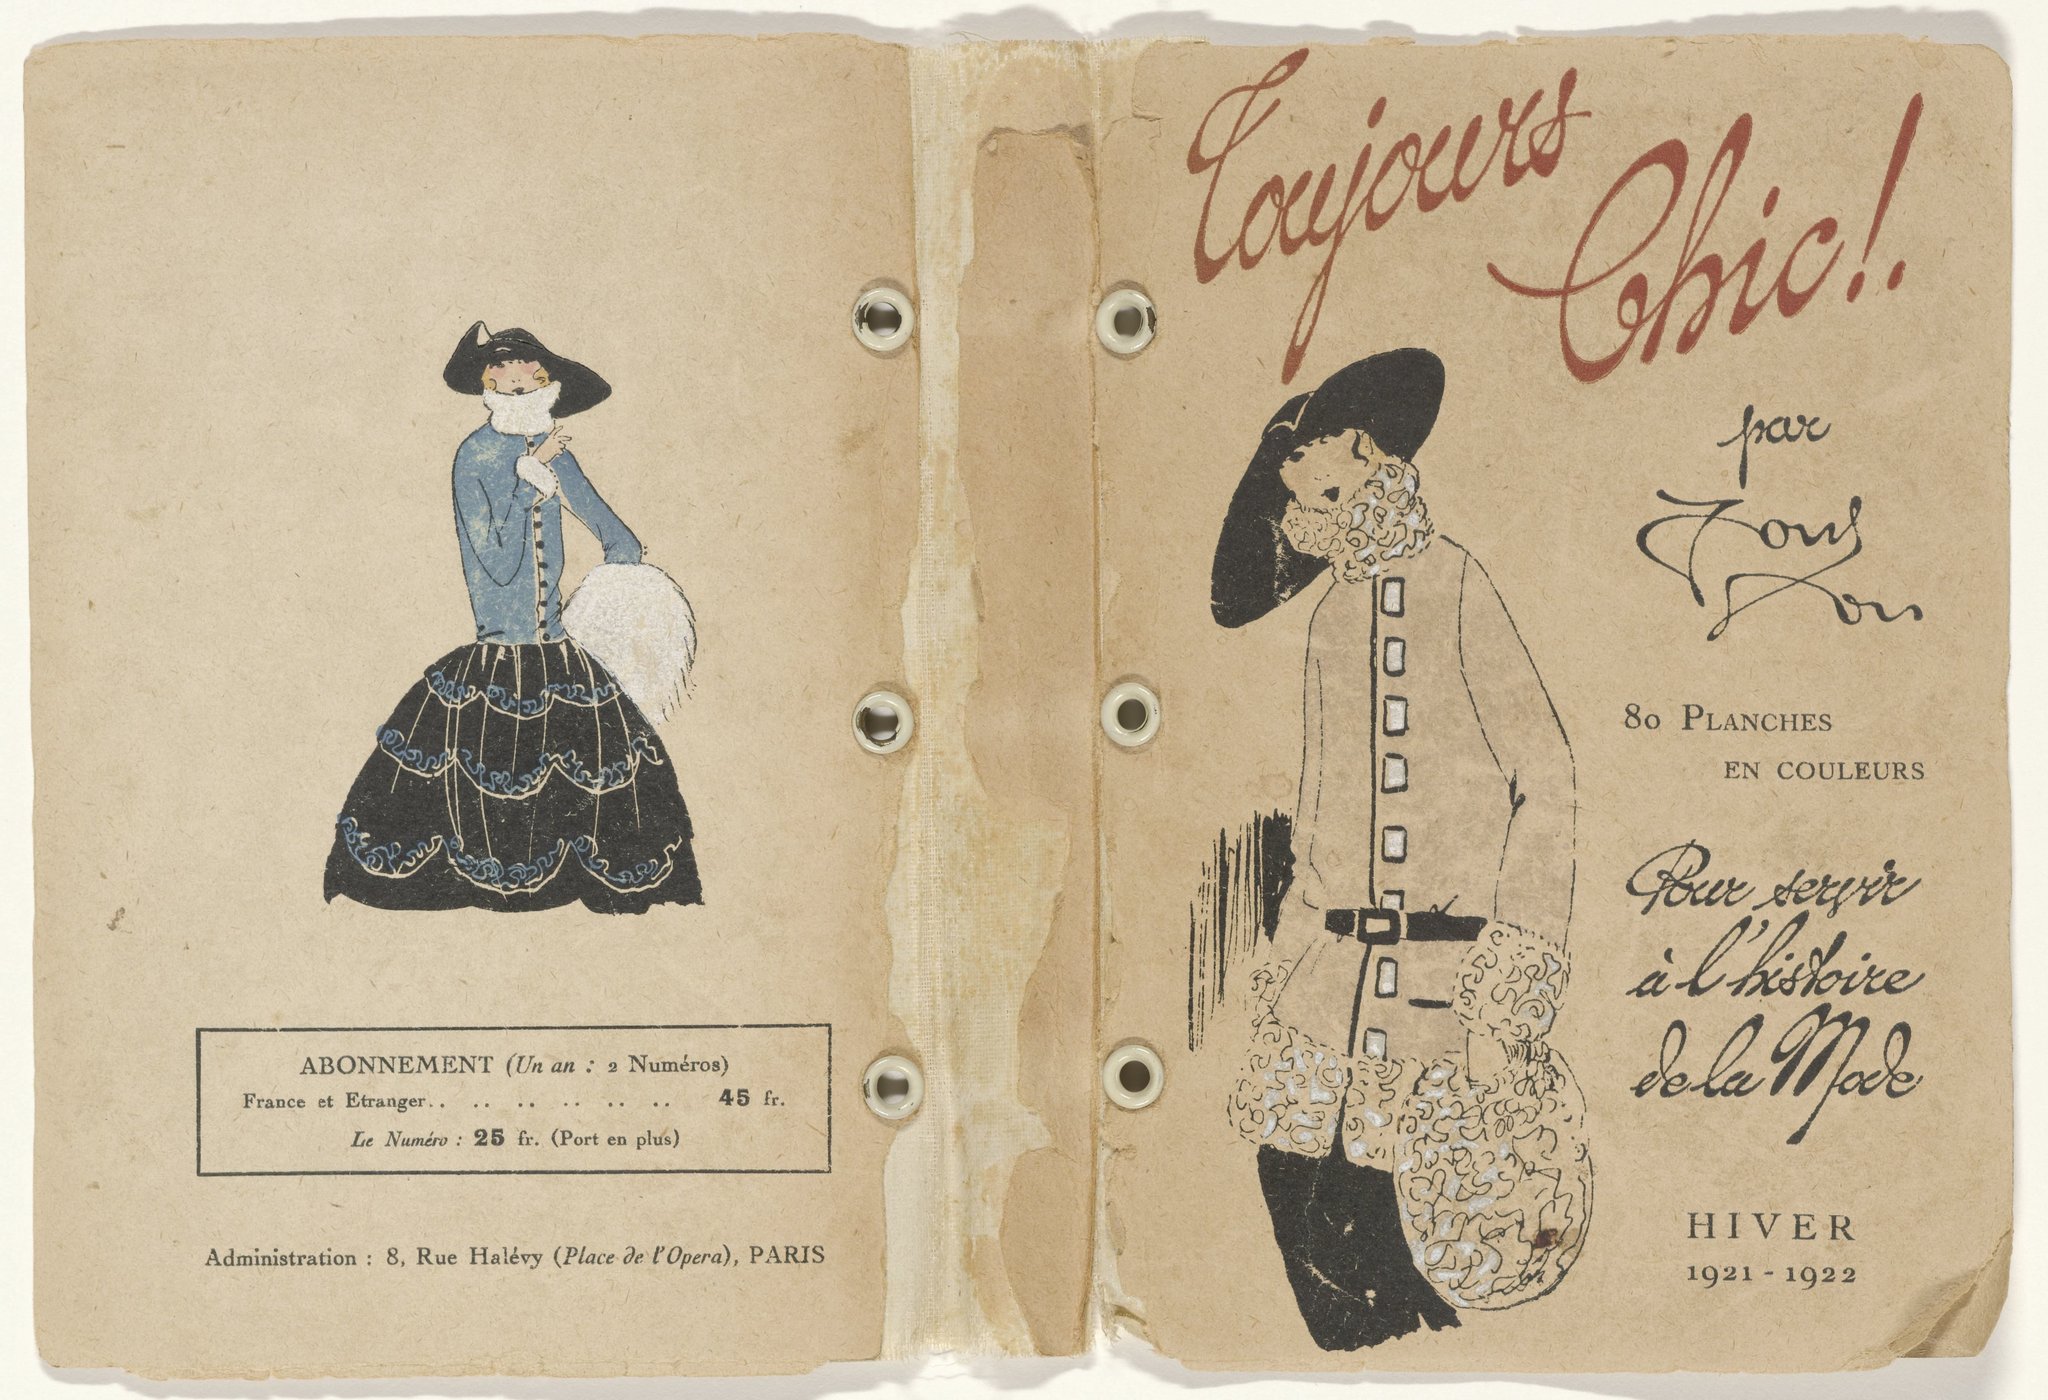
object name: catalog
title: Toujours Chic, catalogus met modeprenten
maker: g-p. joumard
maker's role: publisher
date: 1921-1922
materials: paper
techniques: letterpress printing, pochoir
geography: paris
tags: fashion plates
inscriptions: date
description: Catalogus met een overzicht van de wintermode 1921-1922 in 70 prentjes in pochoir techniek (en 16 pagina's index).